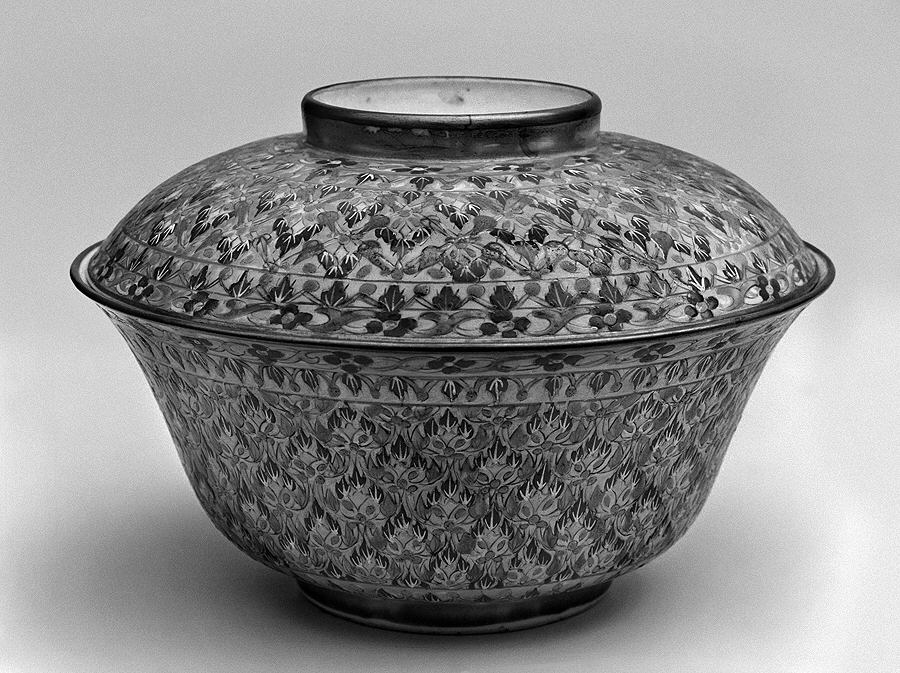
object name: bowl with cover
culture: chinese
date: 1736-1795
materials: porcelain